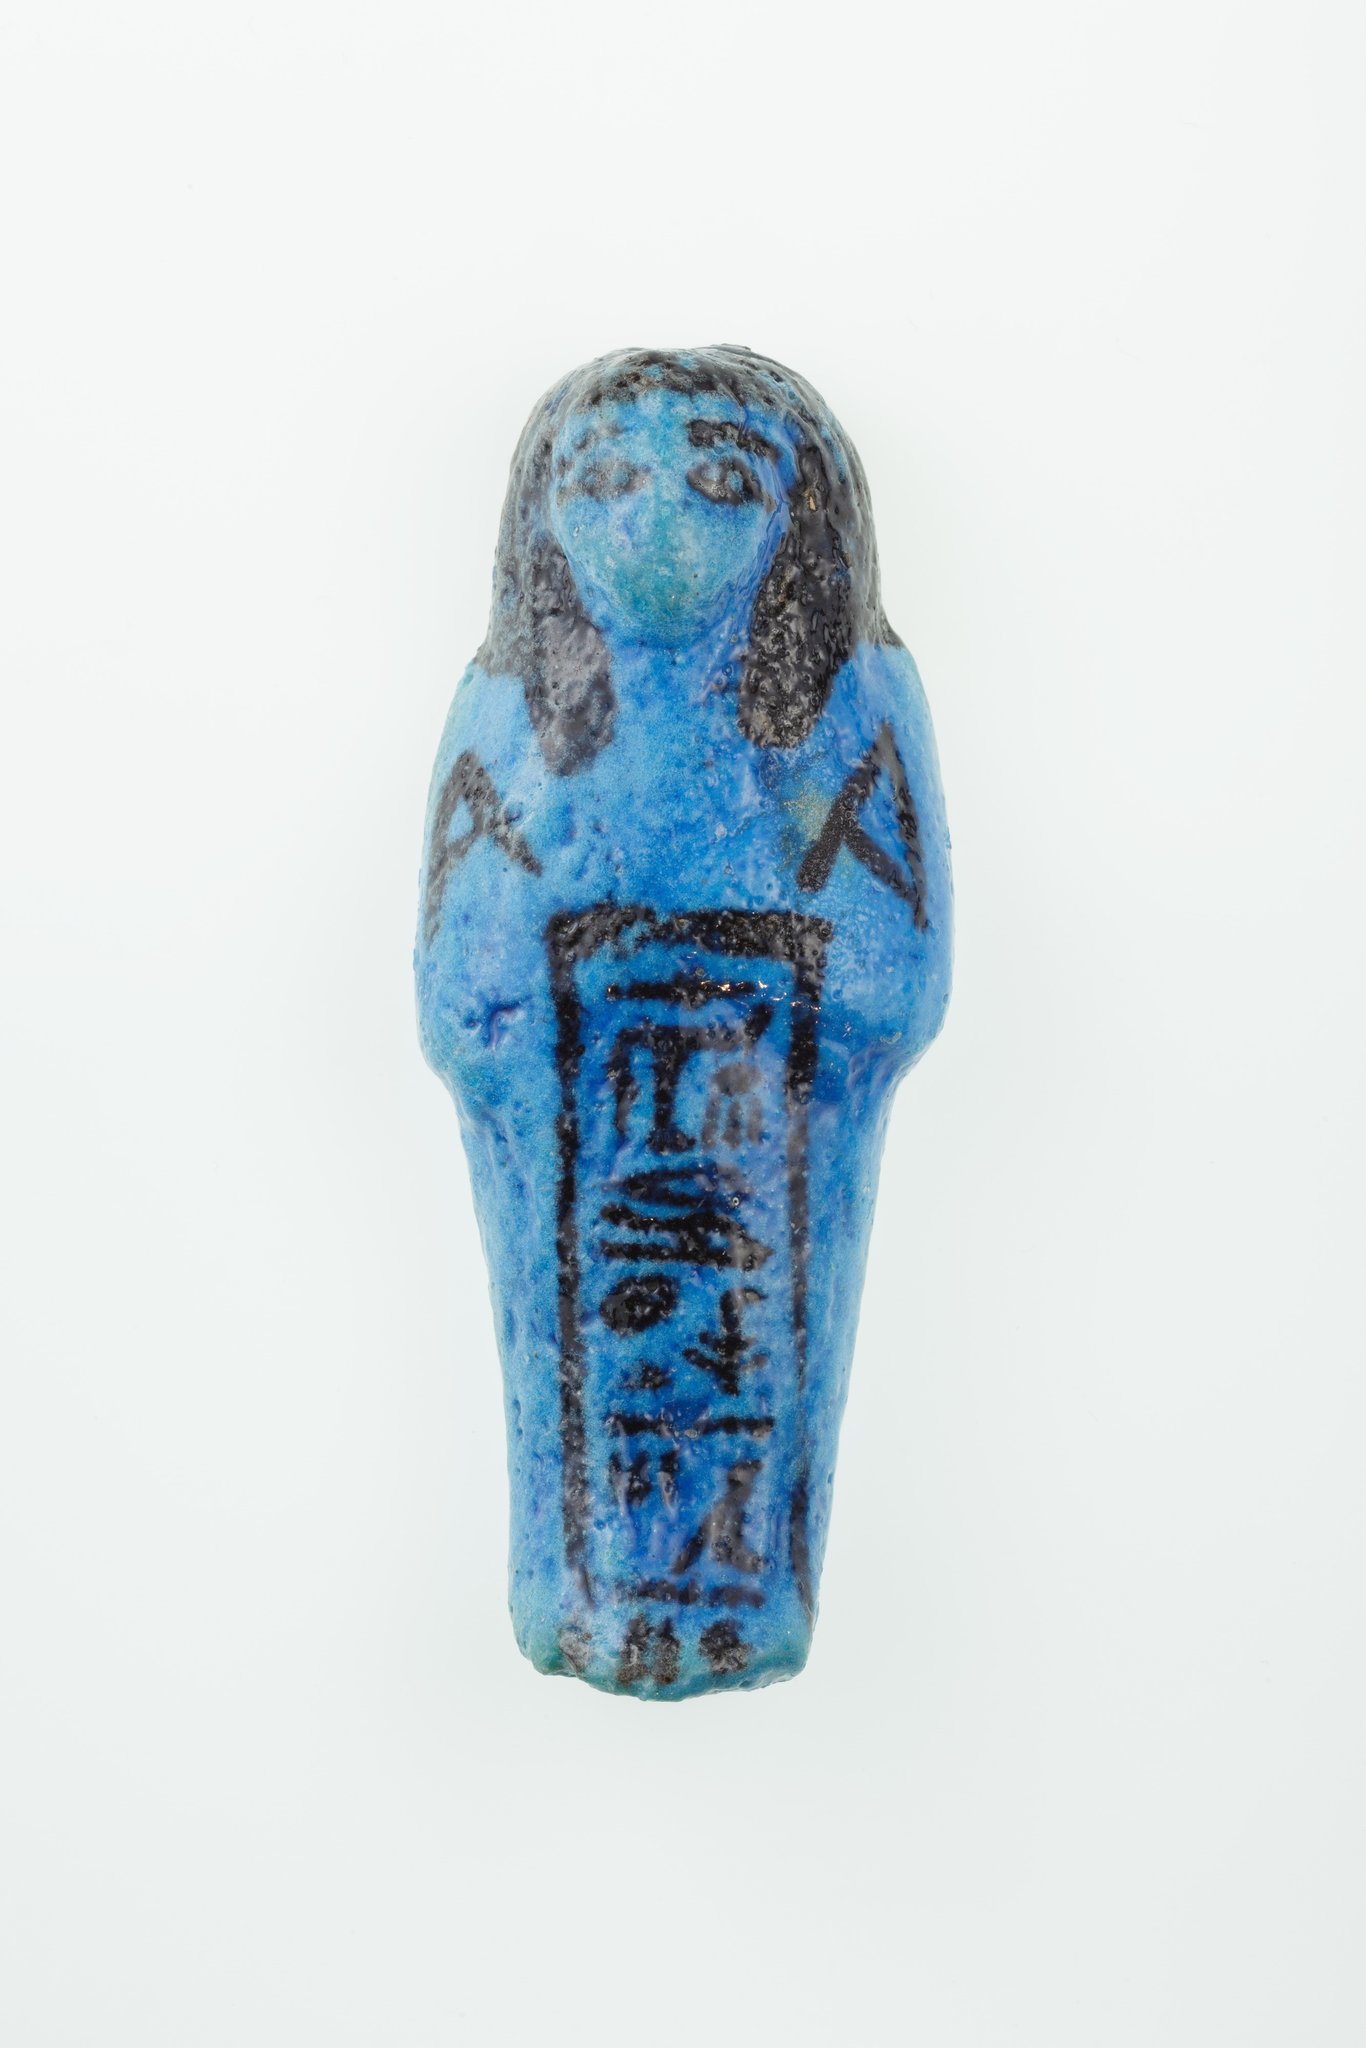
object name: shabti, nauny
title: Worker Shabti of Nauny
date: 1050 BCE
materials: faience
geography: egypt